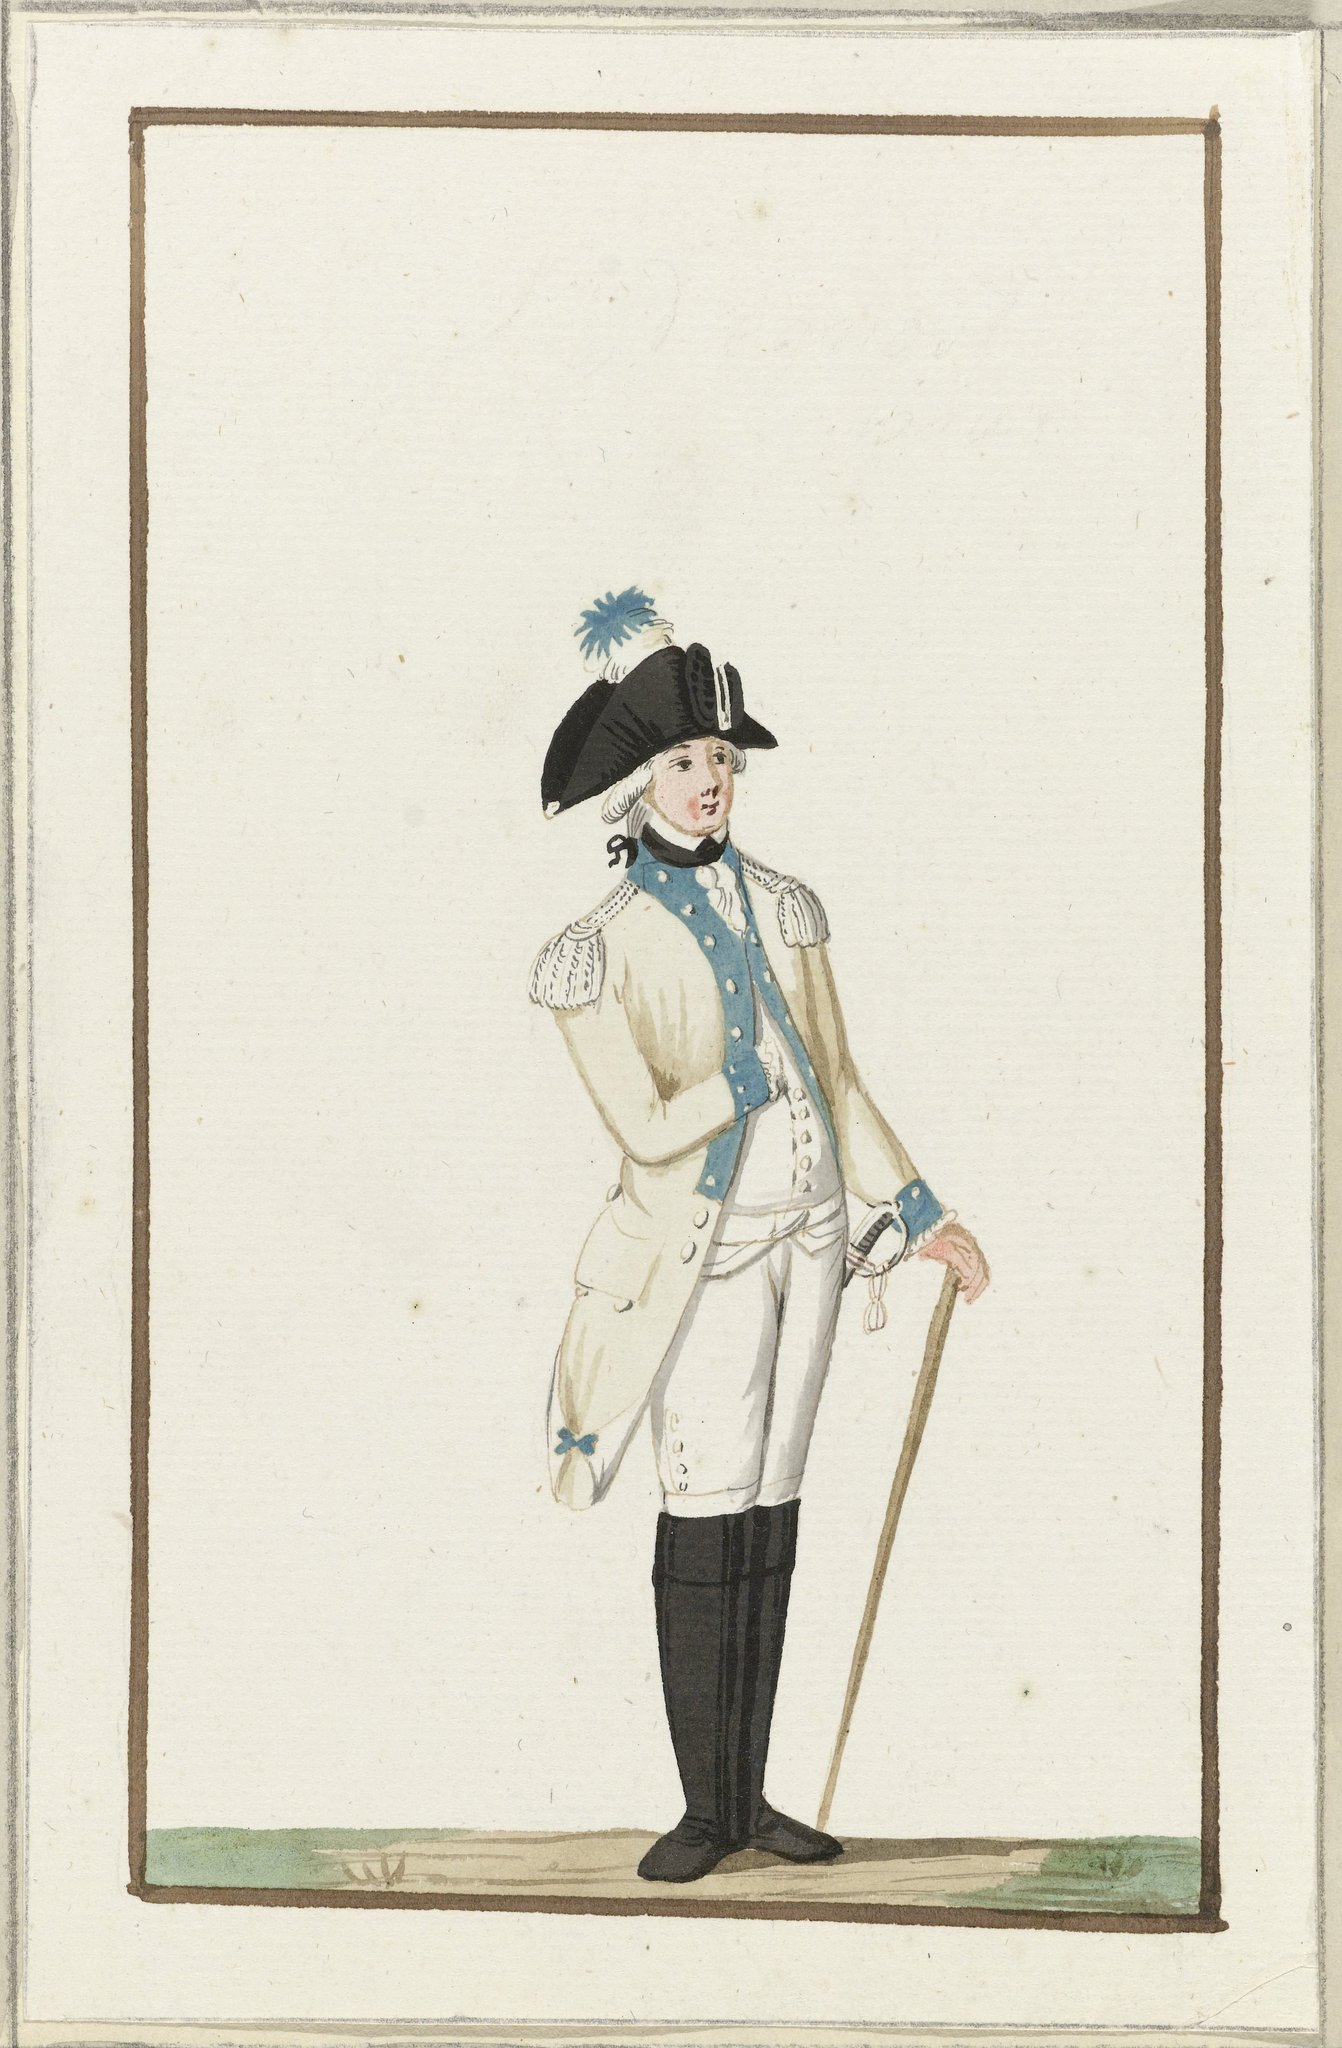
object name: drawing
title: Leyden / Cavallery (Stud: Genootsch:)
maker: Anonymous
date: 1787-1790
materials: paper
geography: northern netherlands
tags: (military) uniforms (+ citizen soldiery, civil guard, citizen militia), leiden, patriots (1780-1795)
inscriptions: collector's mark: Lugt 2228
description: Uniform van de cavalerie van het exercitiegenootschap van de studenten van de Universiteit van Leiden. Onderdeel van een serie van 32 tekeningen van de verschillende monteringen (uniformen) van patriotse schutterijen en burgerkorpsen in Nederland in 1787.